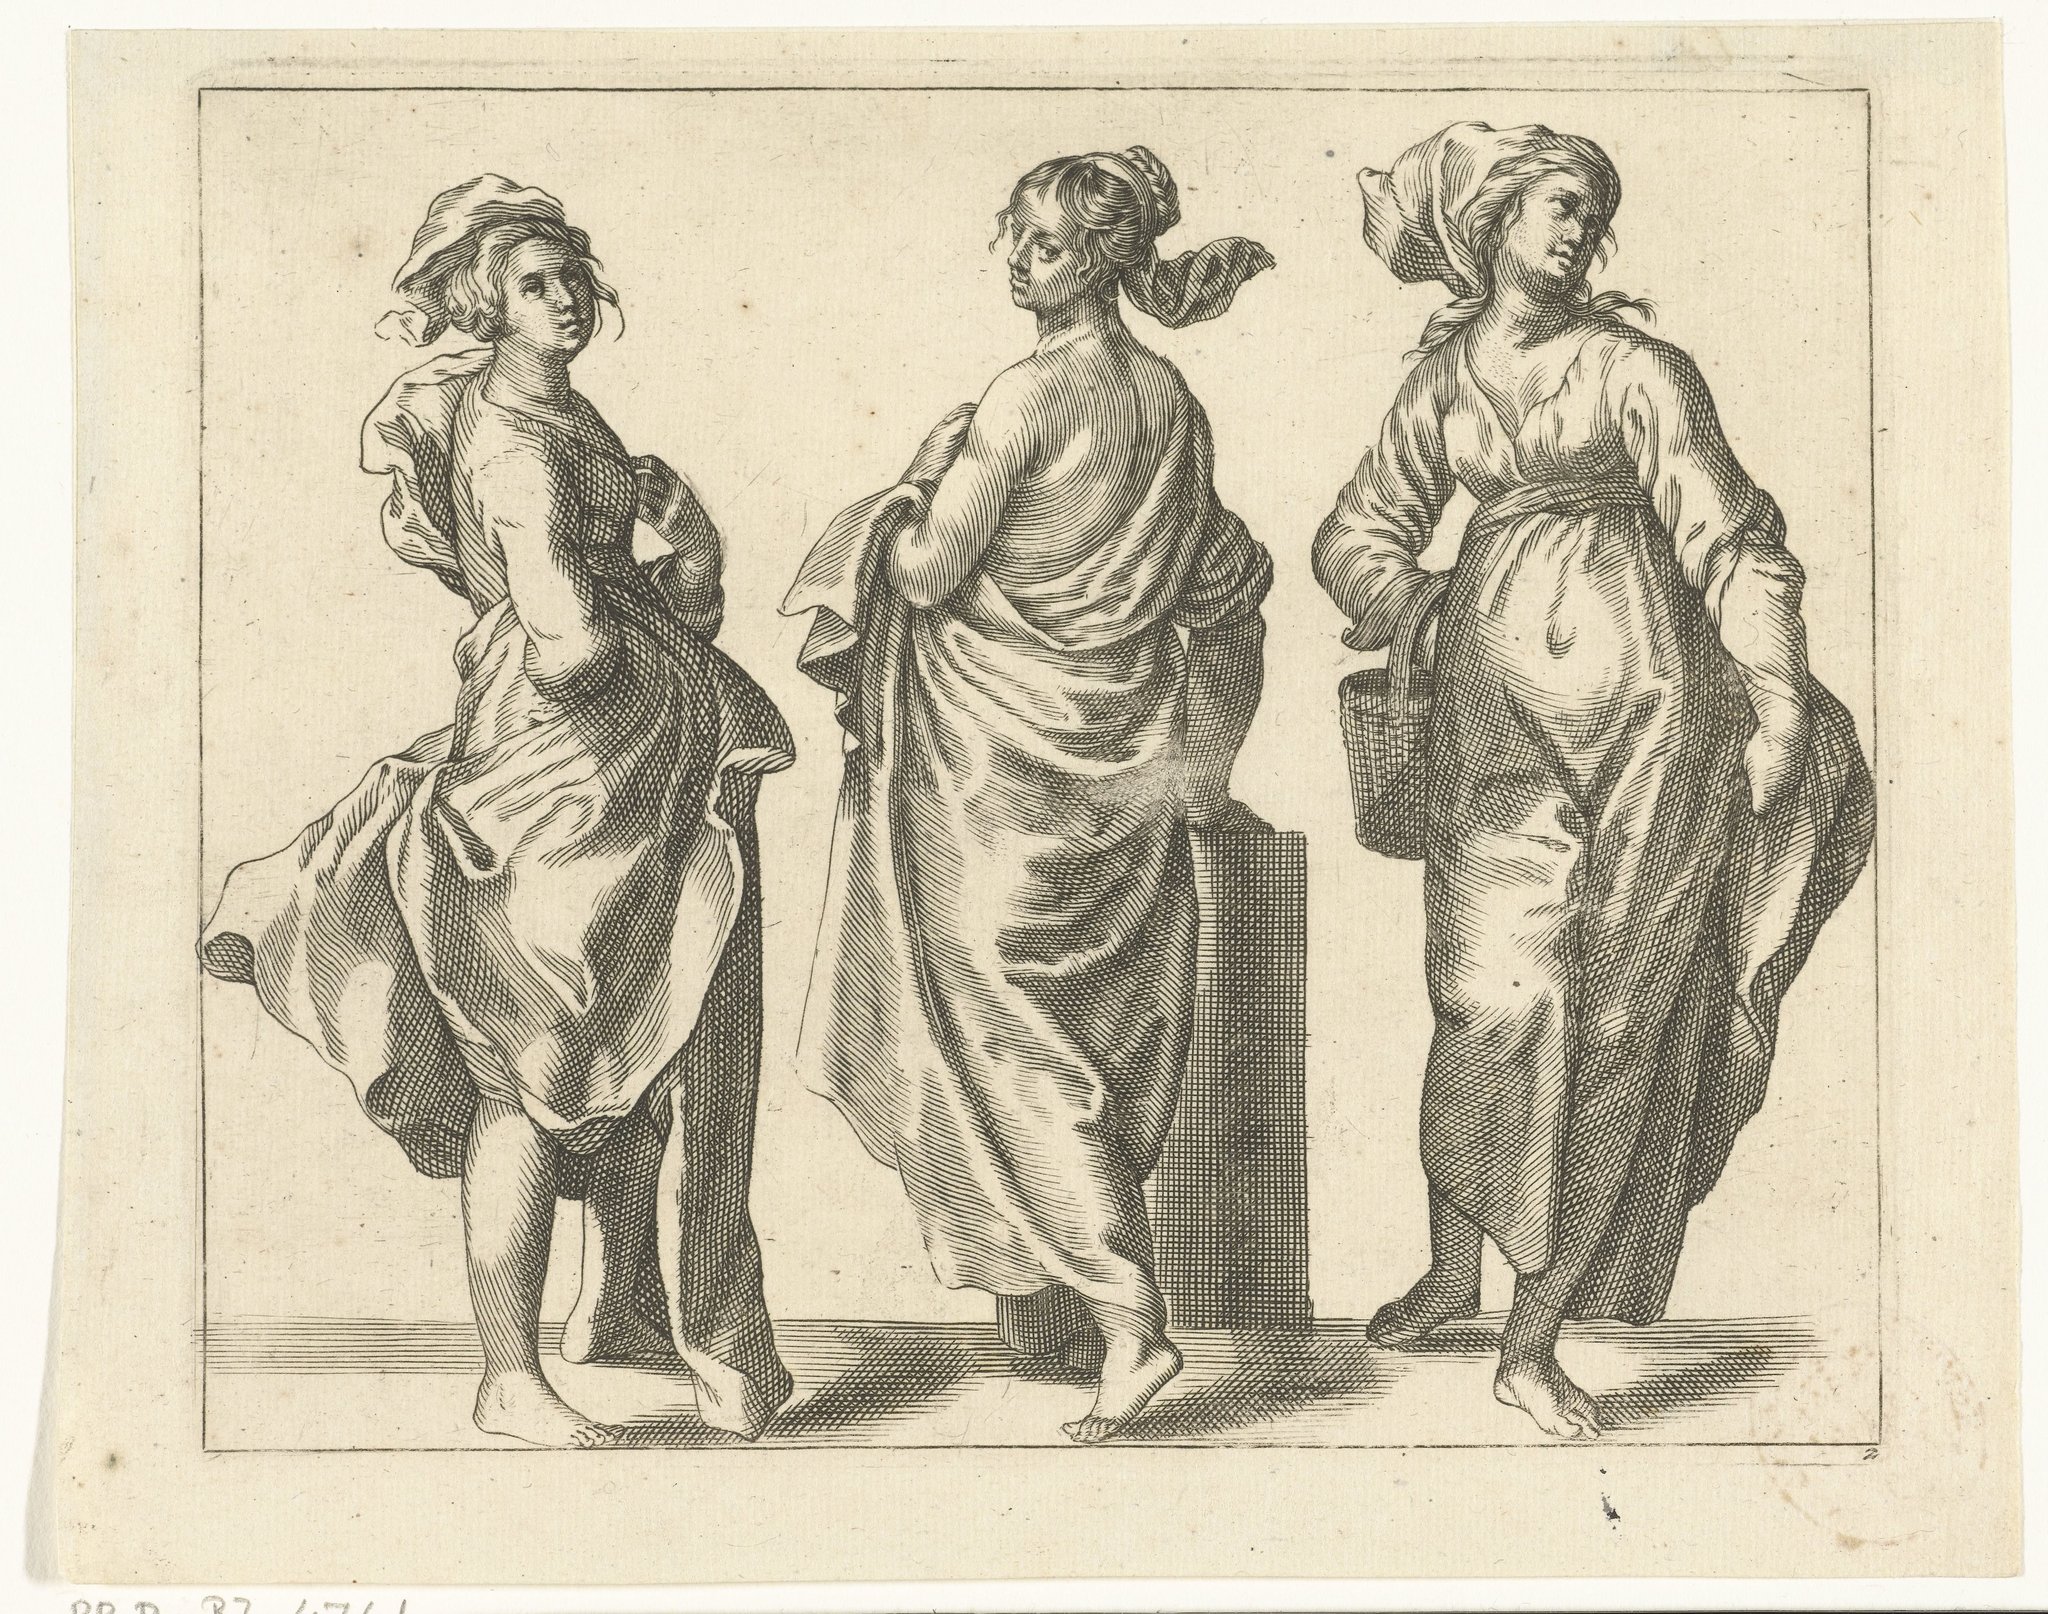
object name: print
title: Verscheyde aerdige figure van vrouwen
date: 1670-1706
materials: paper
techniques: engraving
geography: amsterdam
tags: adult woman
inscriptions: collector's mark: Lugt 240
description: Drie vrouwen in losse kleding: vooraanzicht, zijwaarts en op de rug gezien. Prent twee uit een serie prenten naar figuren uit het tekenboek van Abraham Bloemaert.